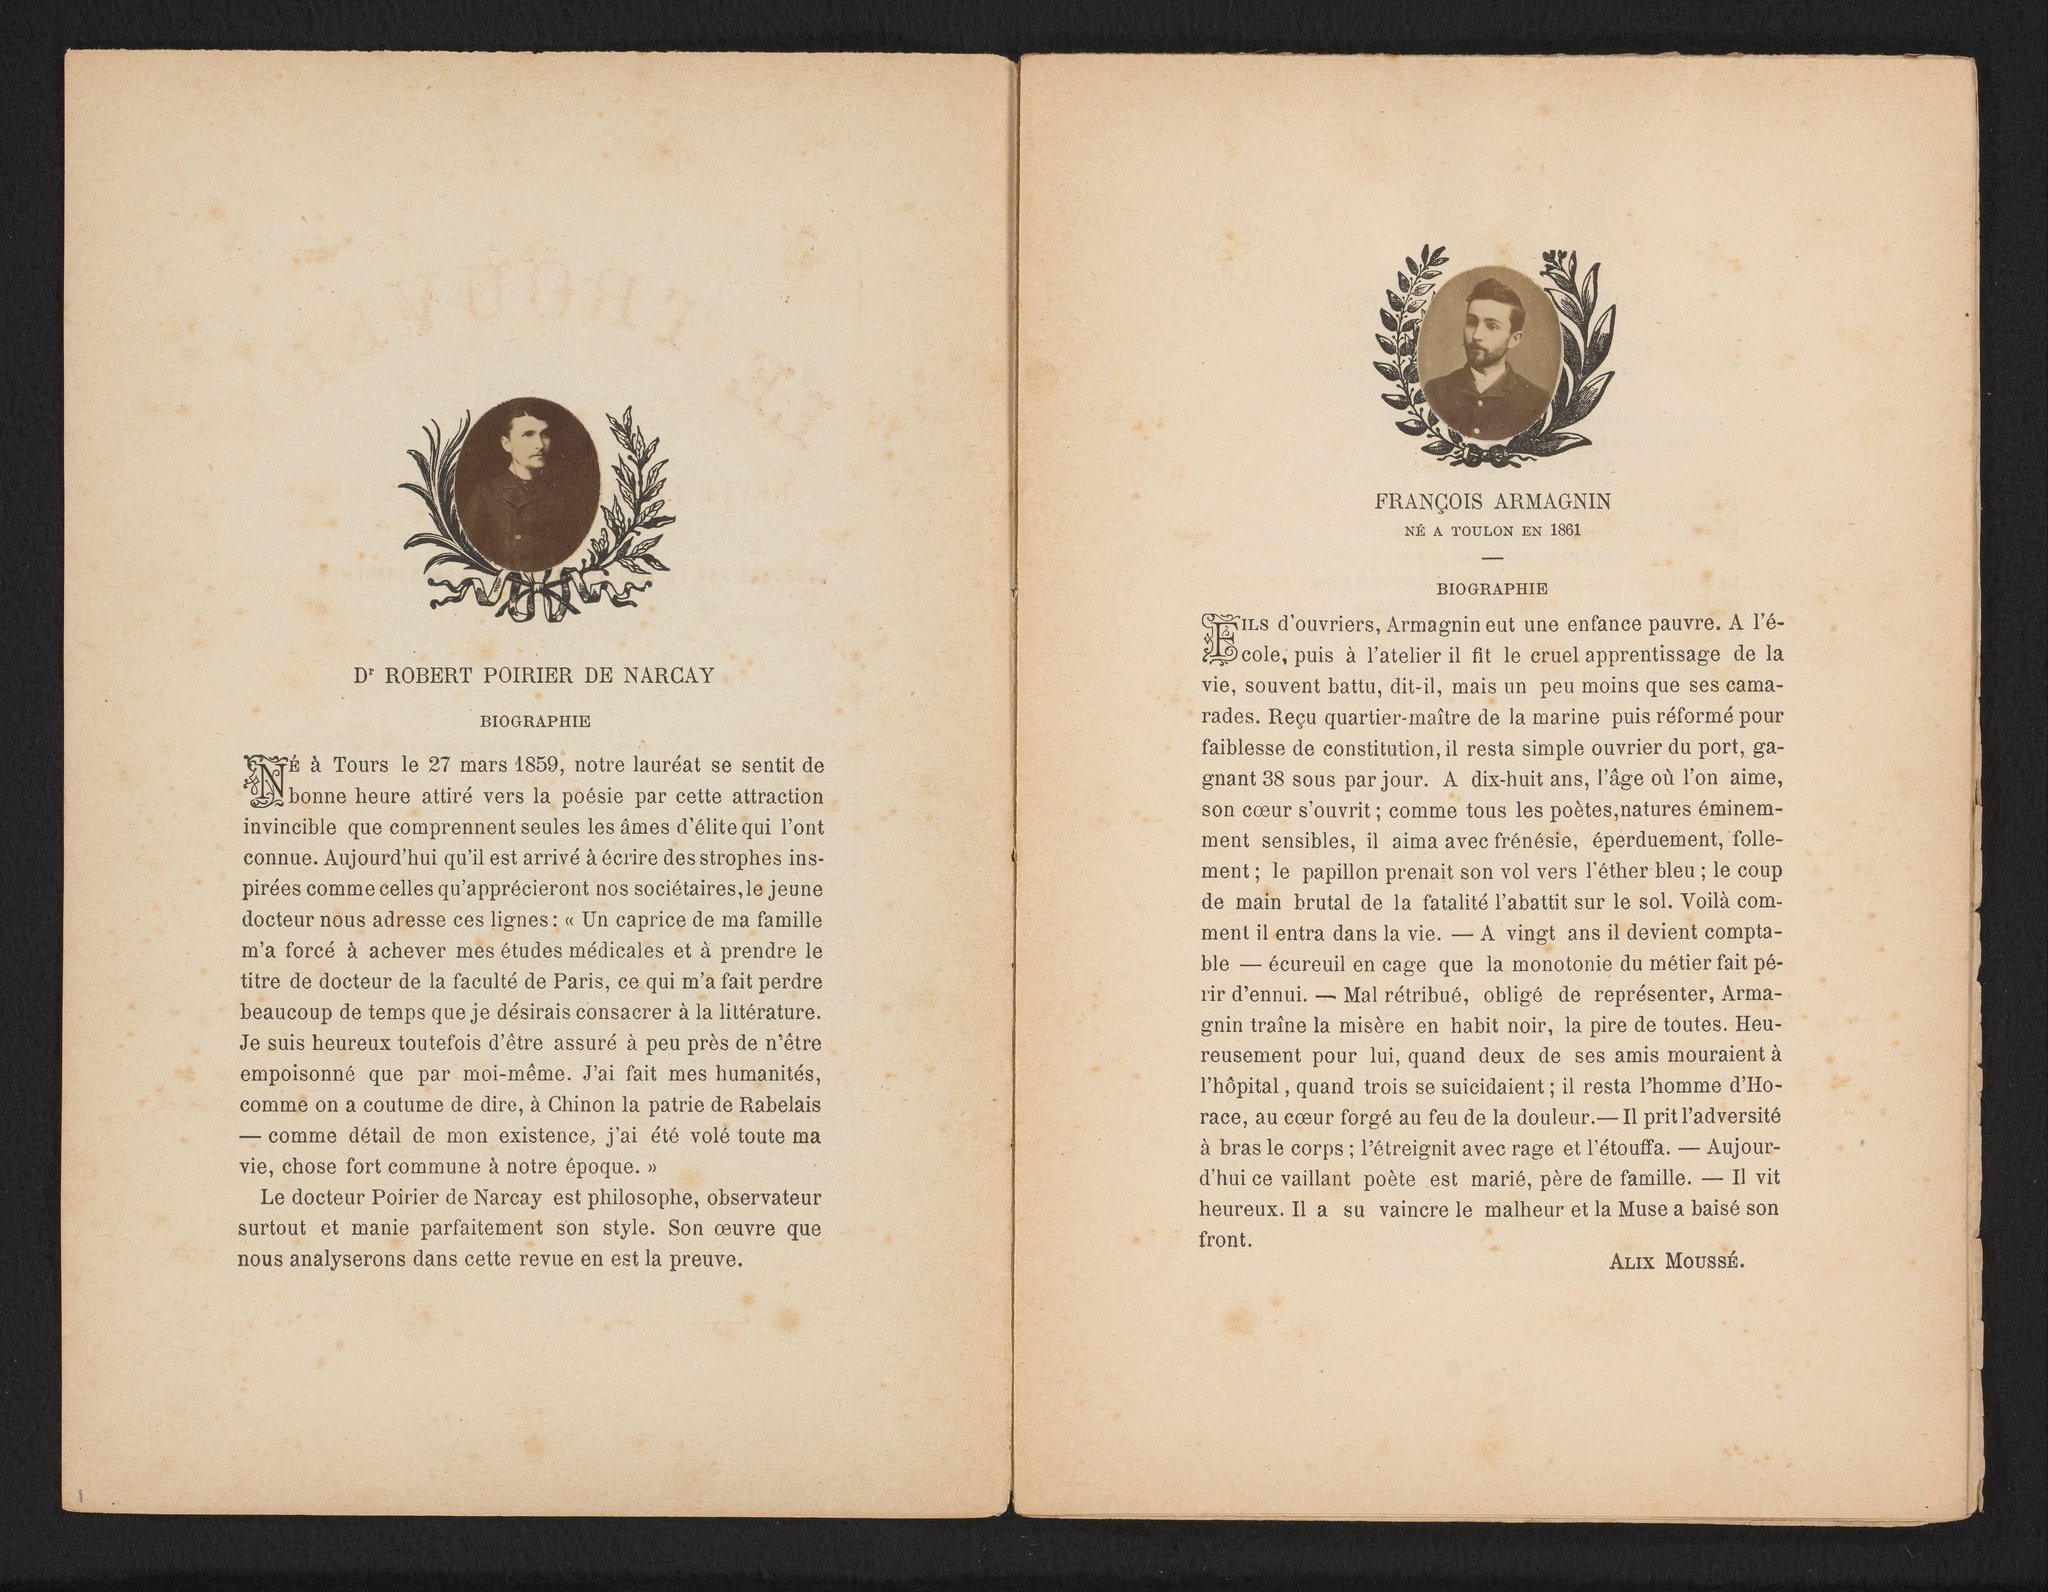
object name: page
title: Portret van François Armagnin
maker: Anonymous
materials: photographic support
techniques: albumen print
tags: toulon, historical persons